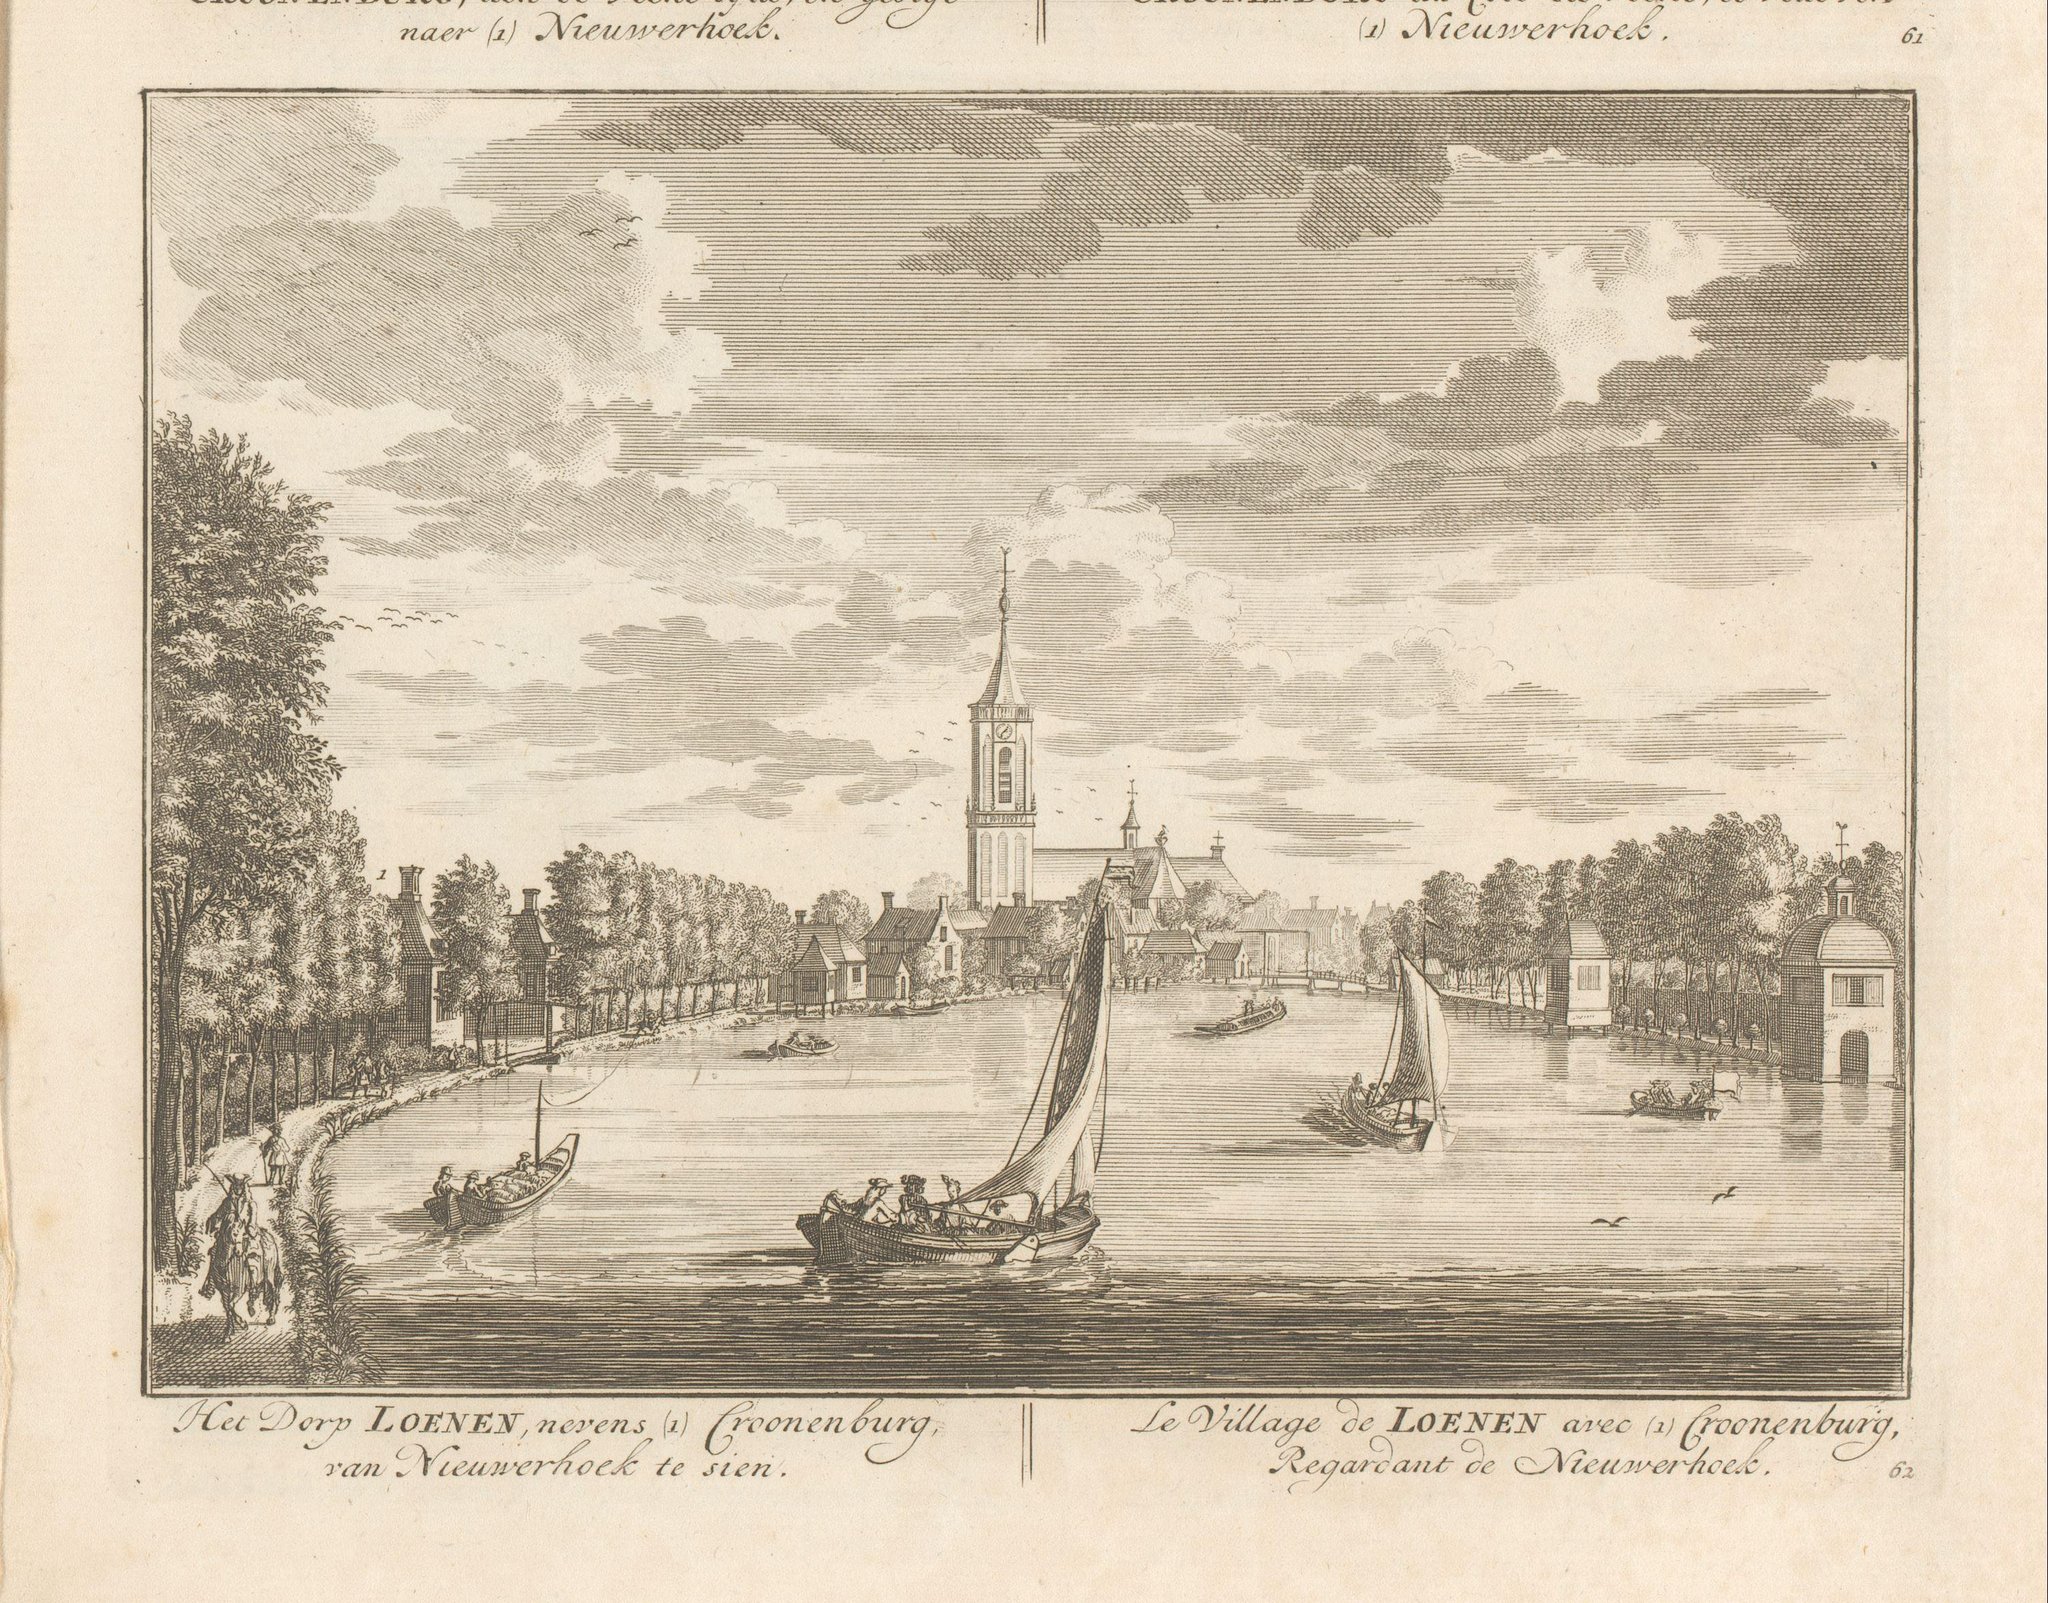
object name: album leaf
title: Het Dorp Loenen, nevens (1) Croonenburg, van Nieuwerhoek te sien / Le Village de Loenen avec (1) Croonenburg, Regardant de Nieuwerhoek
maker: daniël stopendaal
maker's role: print maker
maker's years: 1672-1726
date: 1790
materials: paper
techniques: engraving, etching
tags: river (+ landscape with figures, staffage), traffic on the water, country-house, vecht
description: Prent gebruikt in: Leth, Andries de. De zegepraalende Vecht, vertoonende verscheidene gesichten van lustplaatsen, heeren huysen en dorpen, beginnende van Uitrecht en met Muyden besluytende (...). Amsterdam: Weduwe Nicolaus Visscher, 1719. Prent ook gebruikt in: Brouërius van Nidek, Matthaeus. De Vechtstroom, van Utrecht tot Muiden (...). Amsterdam: H. Gartman, W. Vermandel en J.W. Smit, 1790.